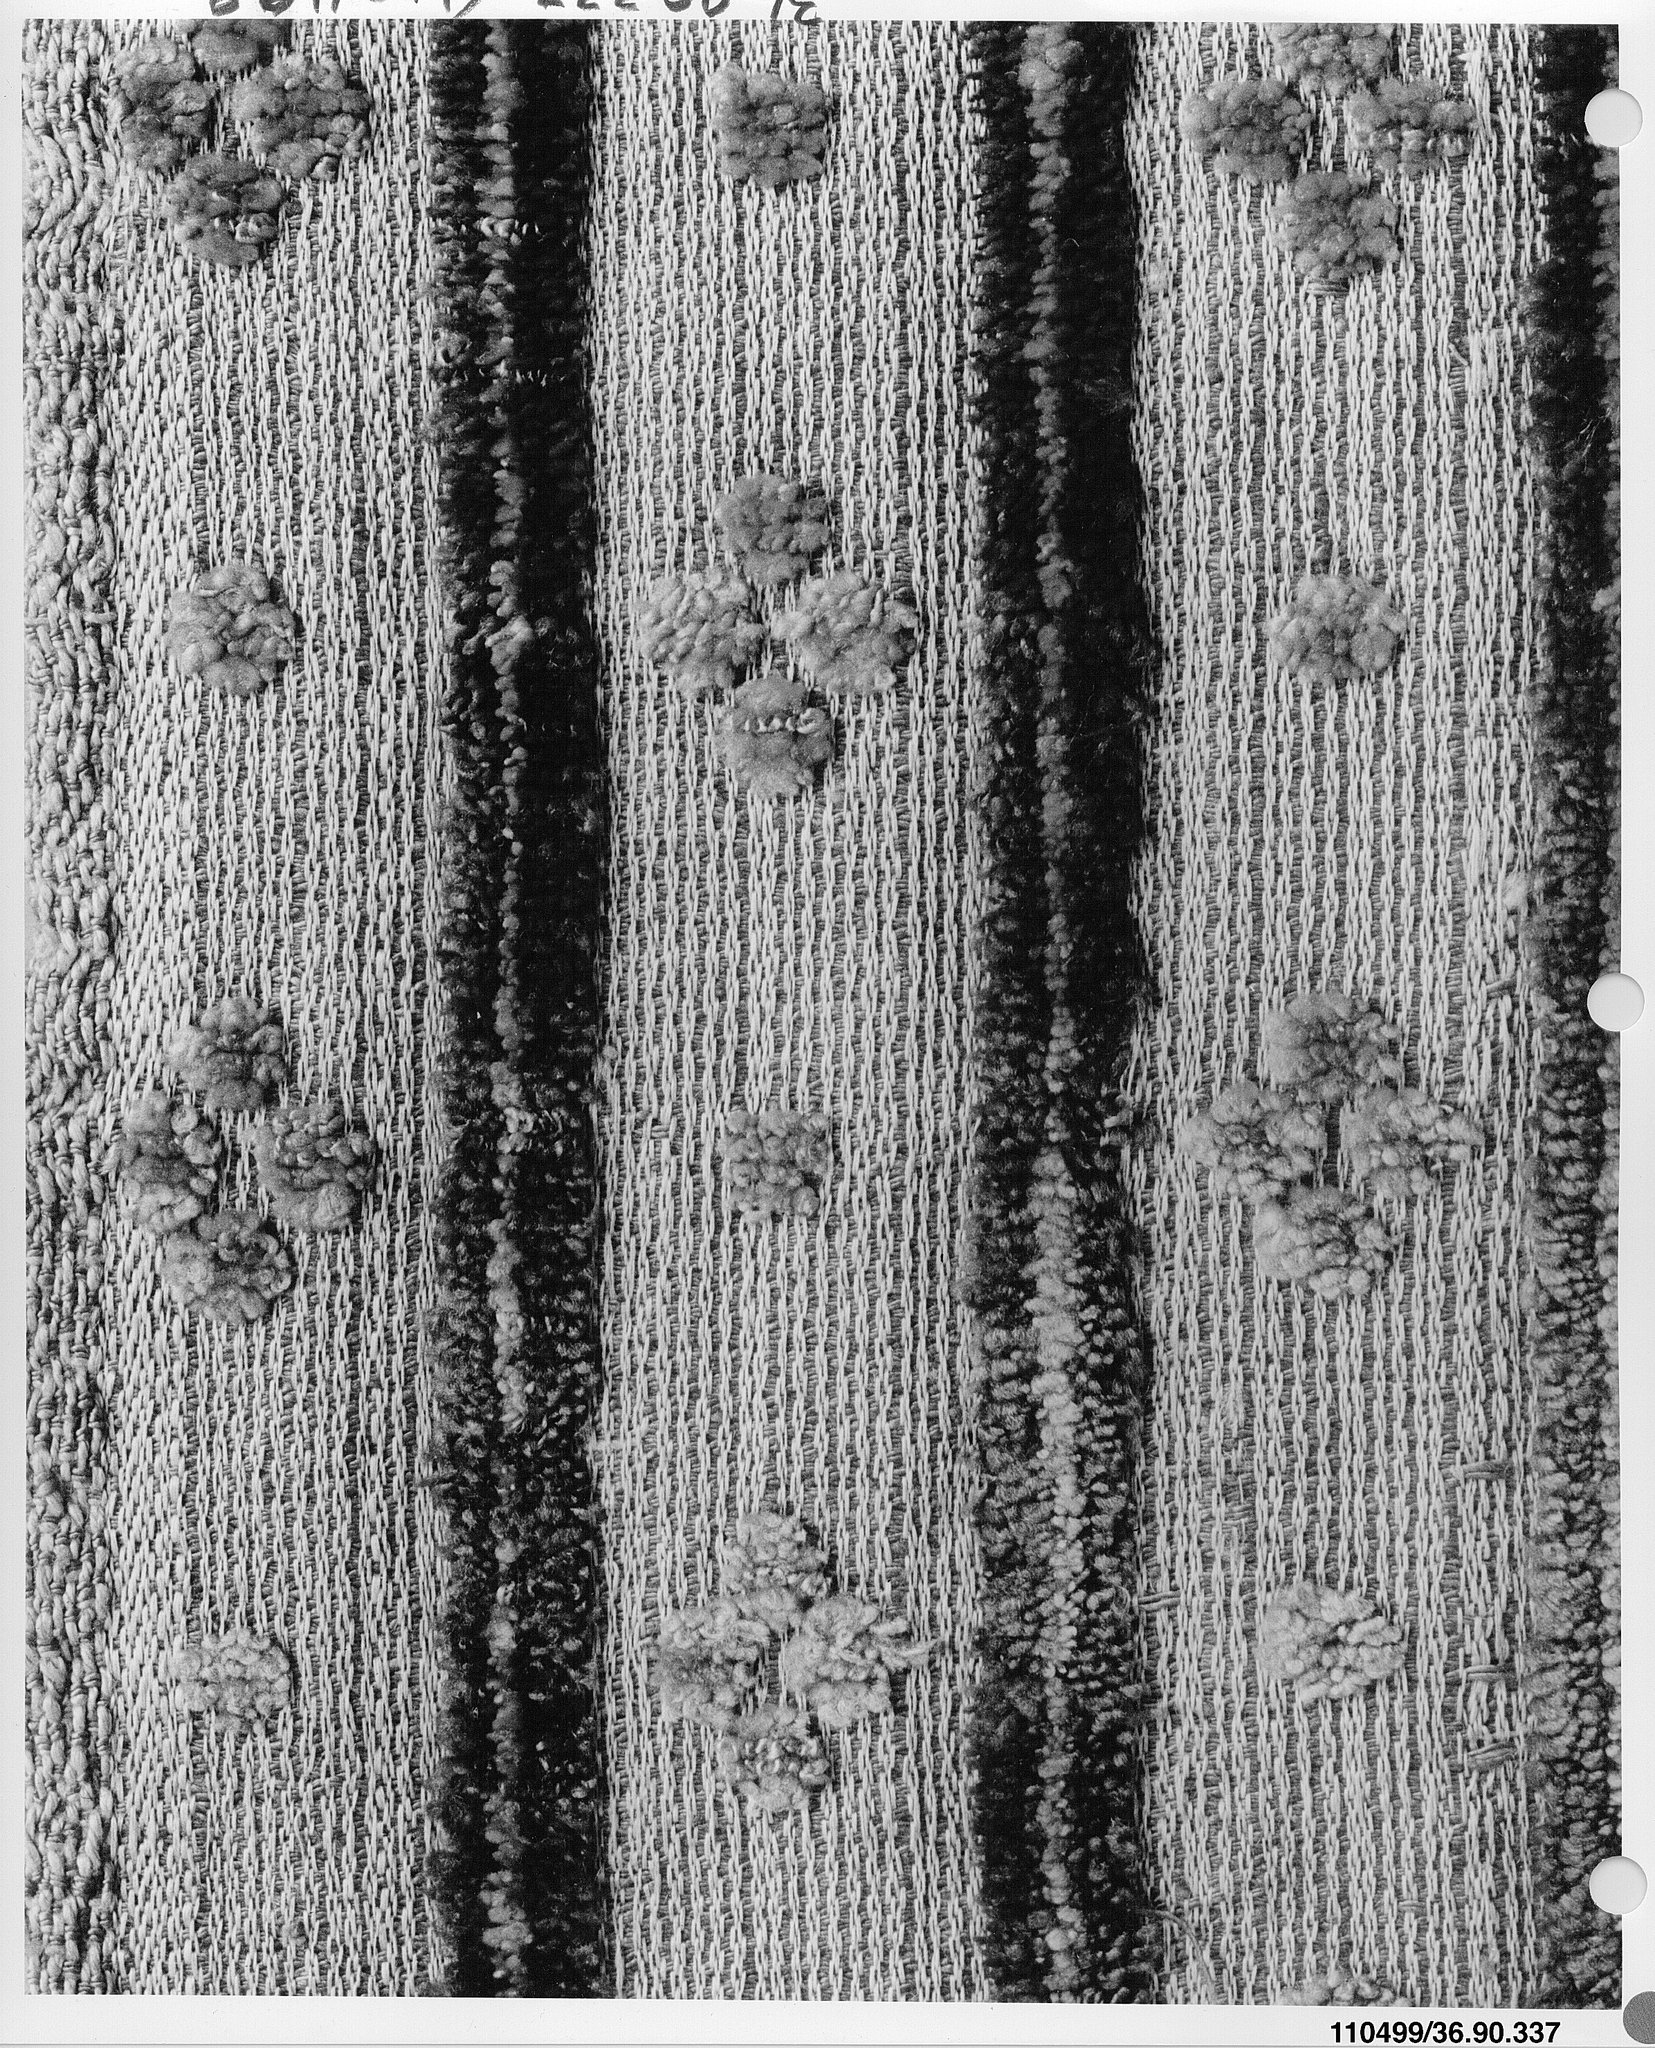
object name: piece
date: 1501-1700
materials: silk